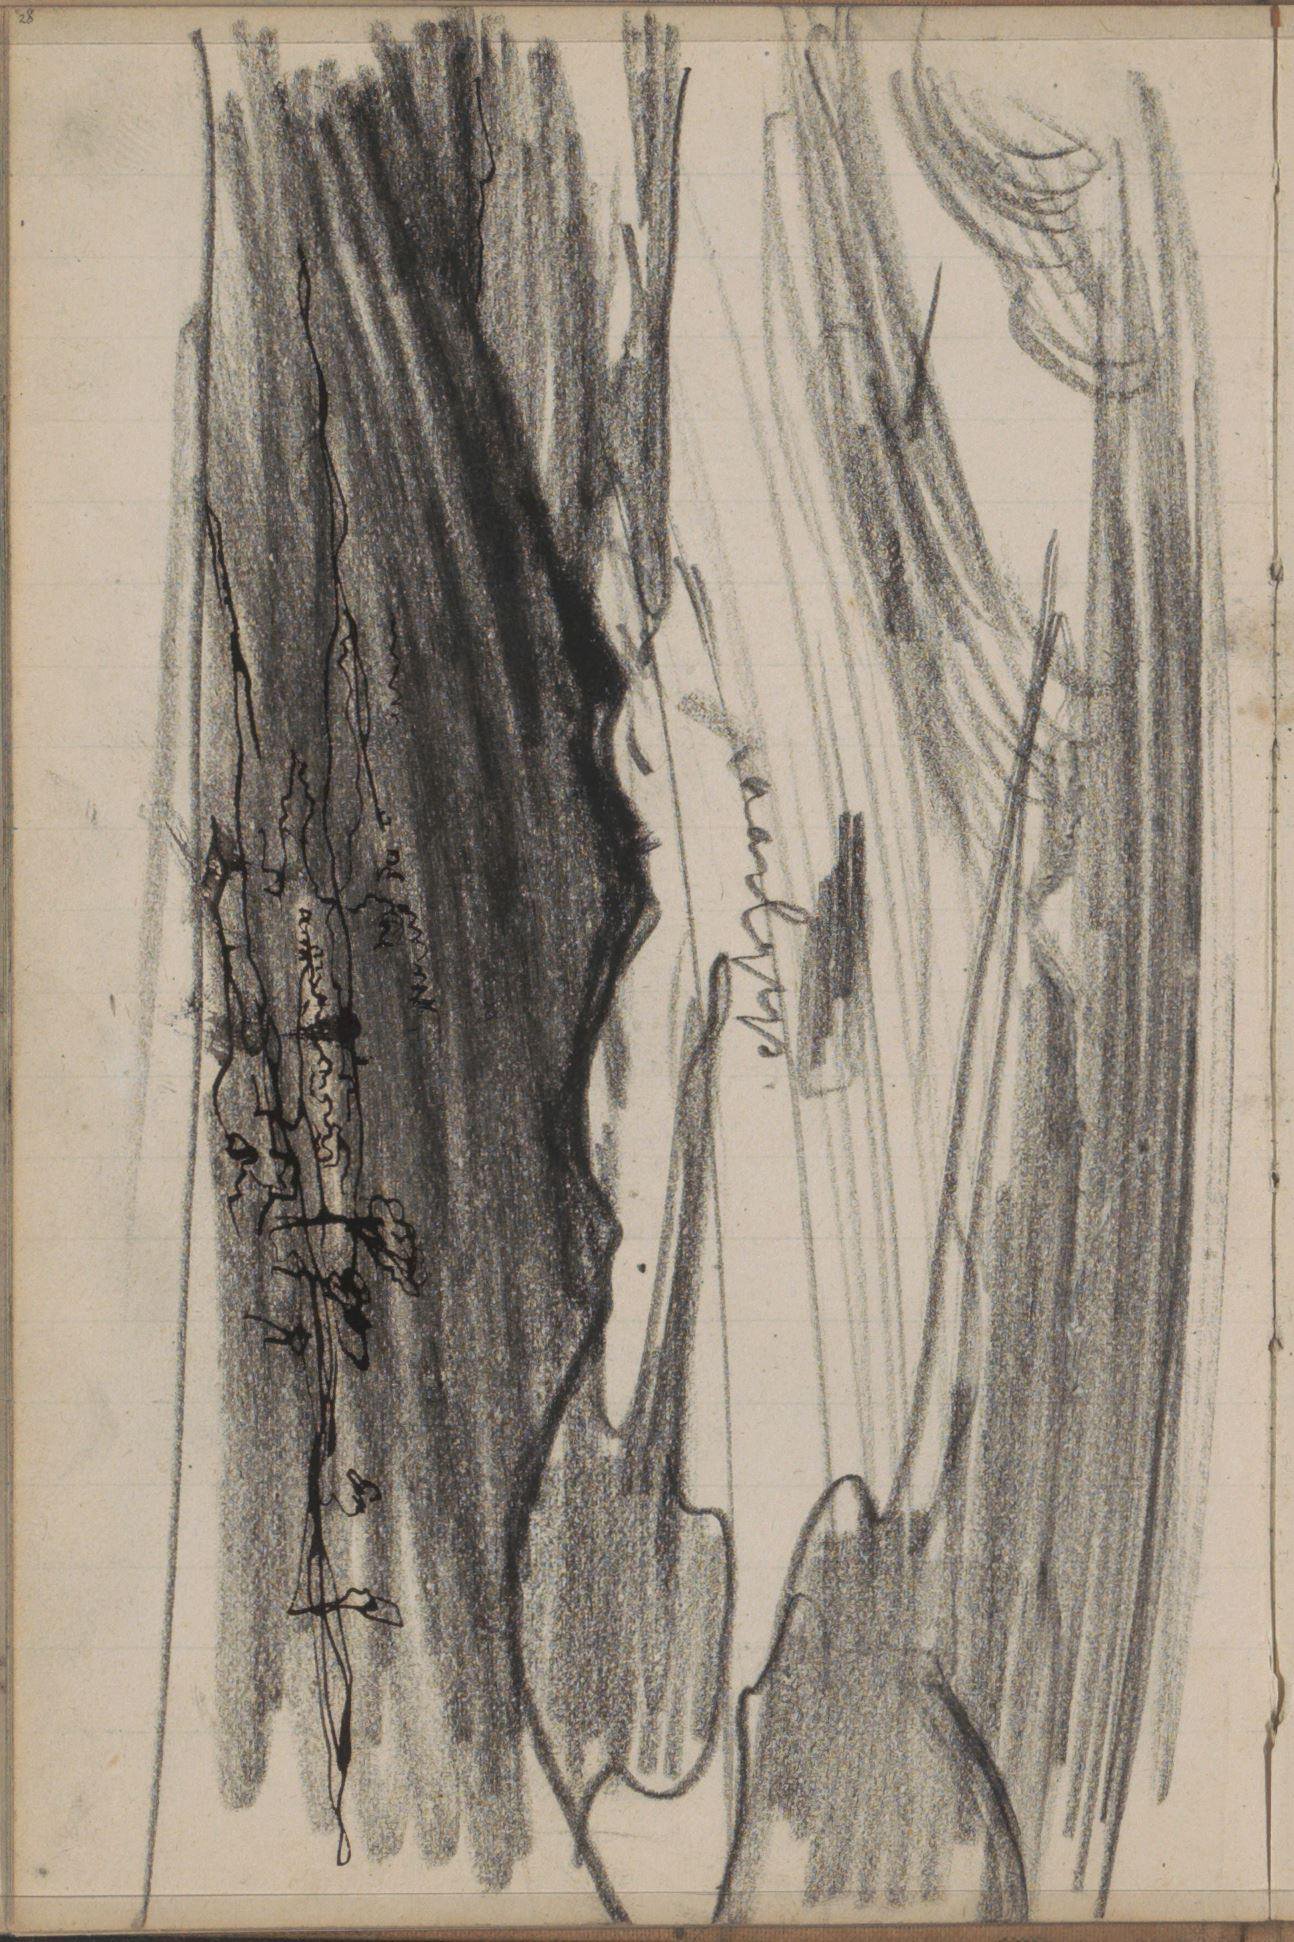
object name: sketchbook leaf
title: Landschap met bomen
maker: marius bauer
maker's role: draughtsman, print maker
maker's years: 1867-1932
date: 1888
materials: chalk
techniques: pen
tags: trees, landscapes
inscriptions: kleurnotitie, handgeschreven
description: Pagina 28 uit een schetsboek met 49 bladen.